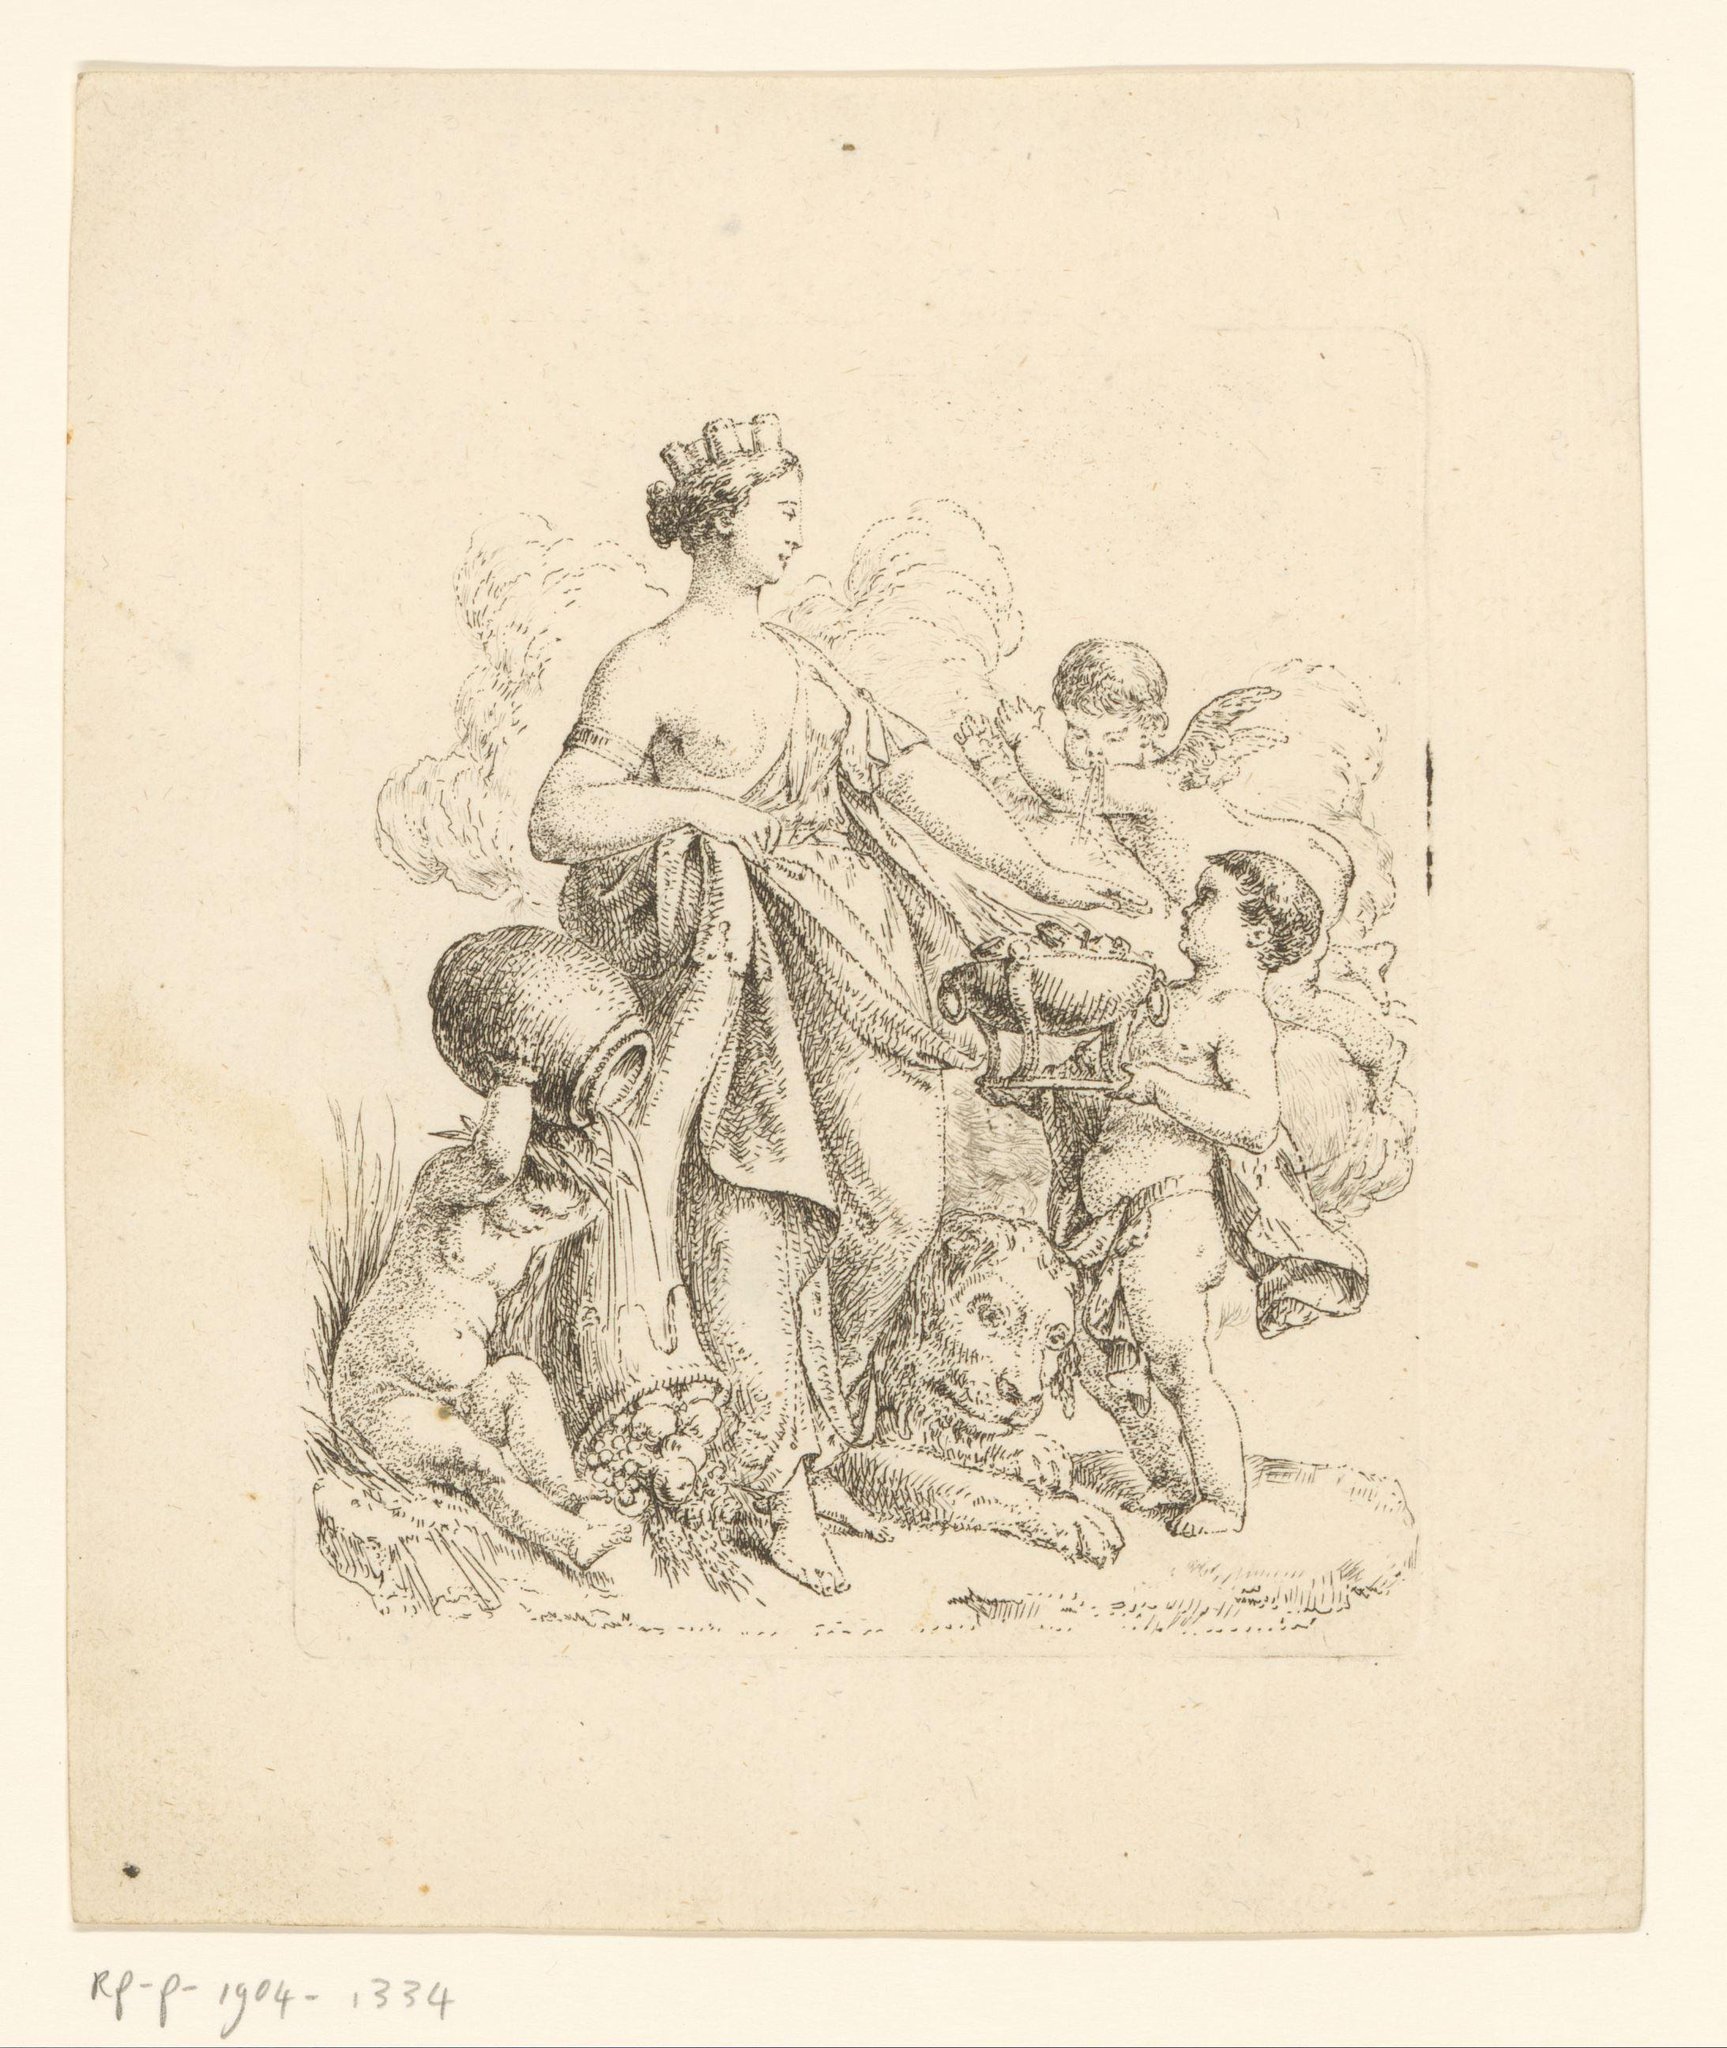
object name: print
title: Allegorie van de eerbied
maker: bernhard rode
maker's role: artist, print maker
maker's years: 1725-1797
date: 1788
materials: paper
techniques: etching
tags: respect, reverence, esteem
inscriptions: collector's mark: Lugt 2228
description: Prent ook gebruikt in: Ramler, Karl Wilhelm. Allegorische Personen zum Gebrauche der bildenden Künstler. Berlijn: Akademischen Kunst- und Buchhandlung, 1788.